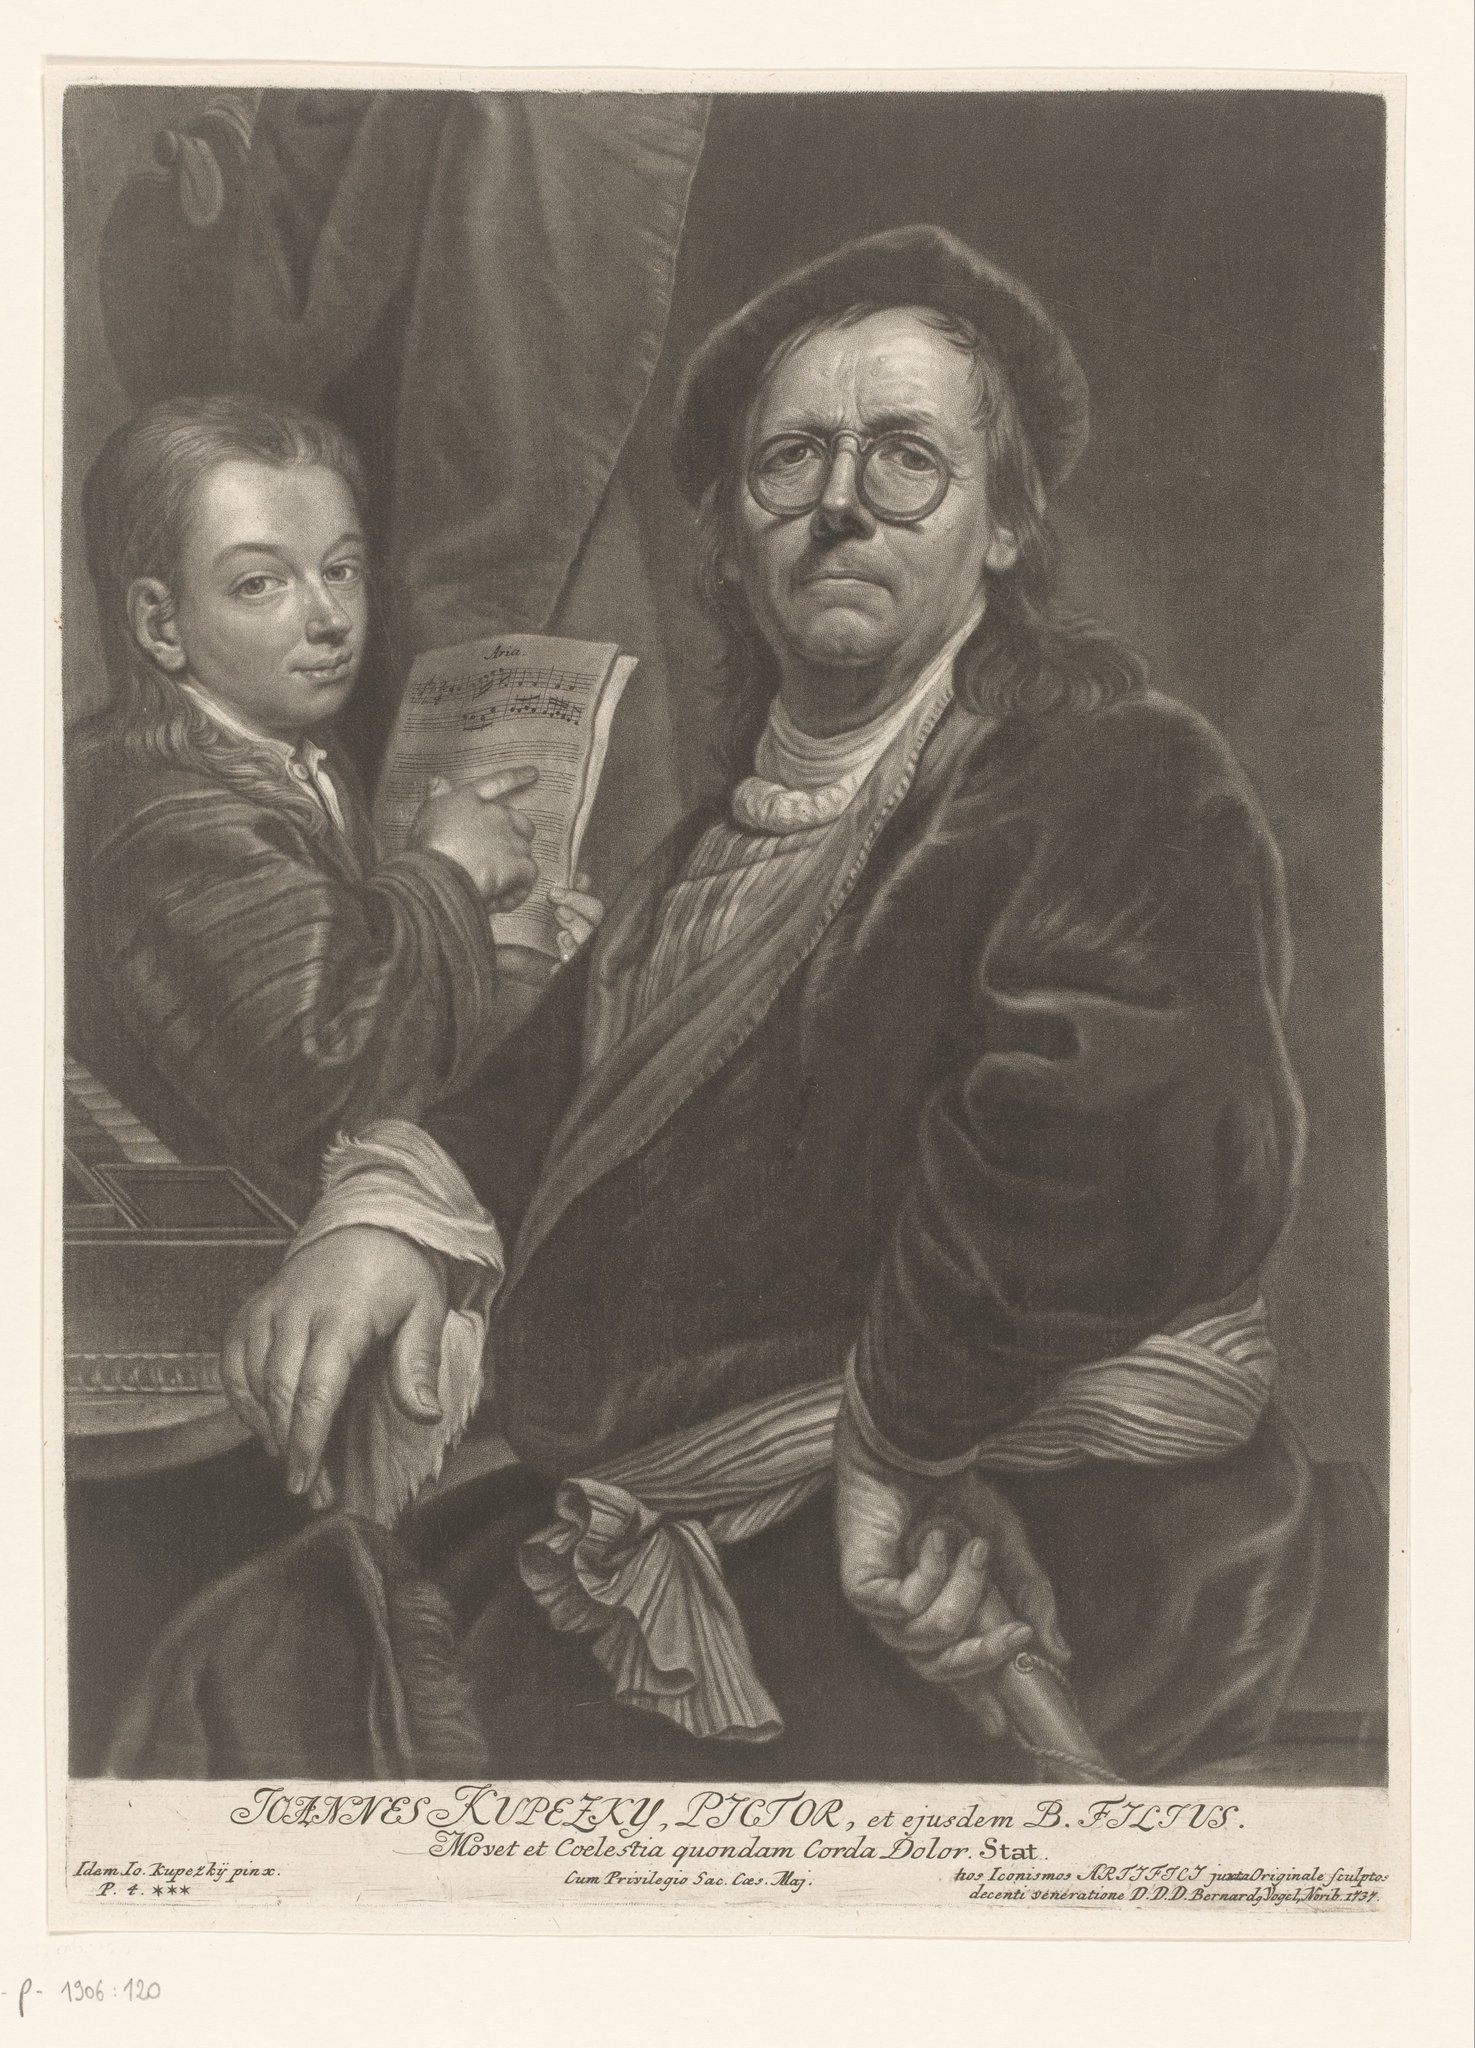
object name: print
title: Zelfportret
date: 1737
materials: paper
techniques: mezzotint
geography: nuremberg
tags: draughtsman, jan kupecký, portrait, self-portrait of graphic artist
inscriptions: collector's mark: Lugt 2228